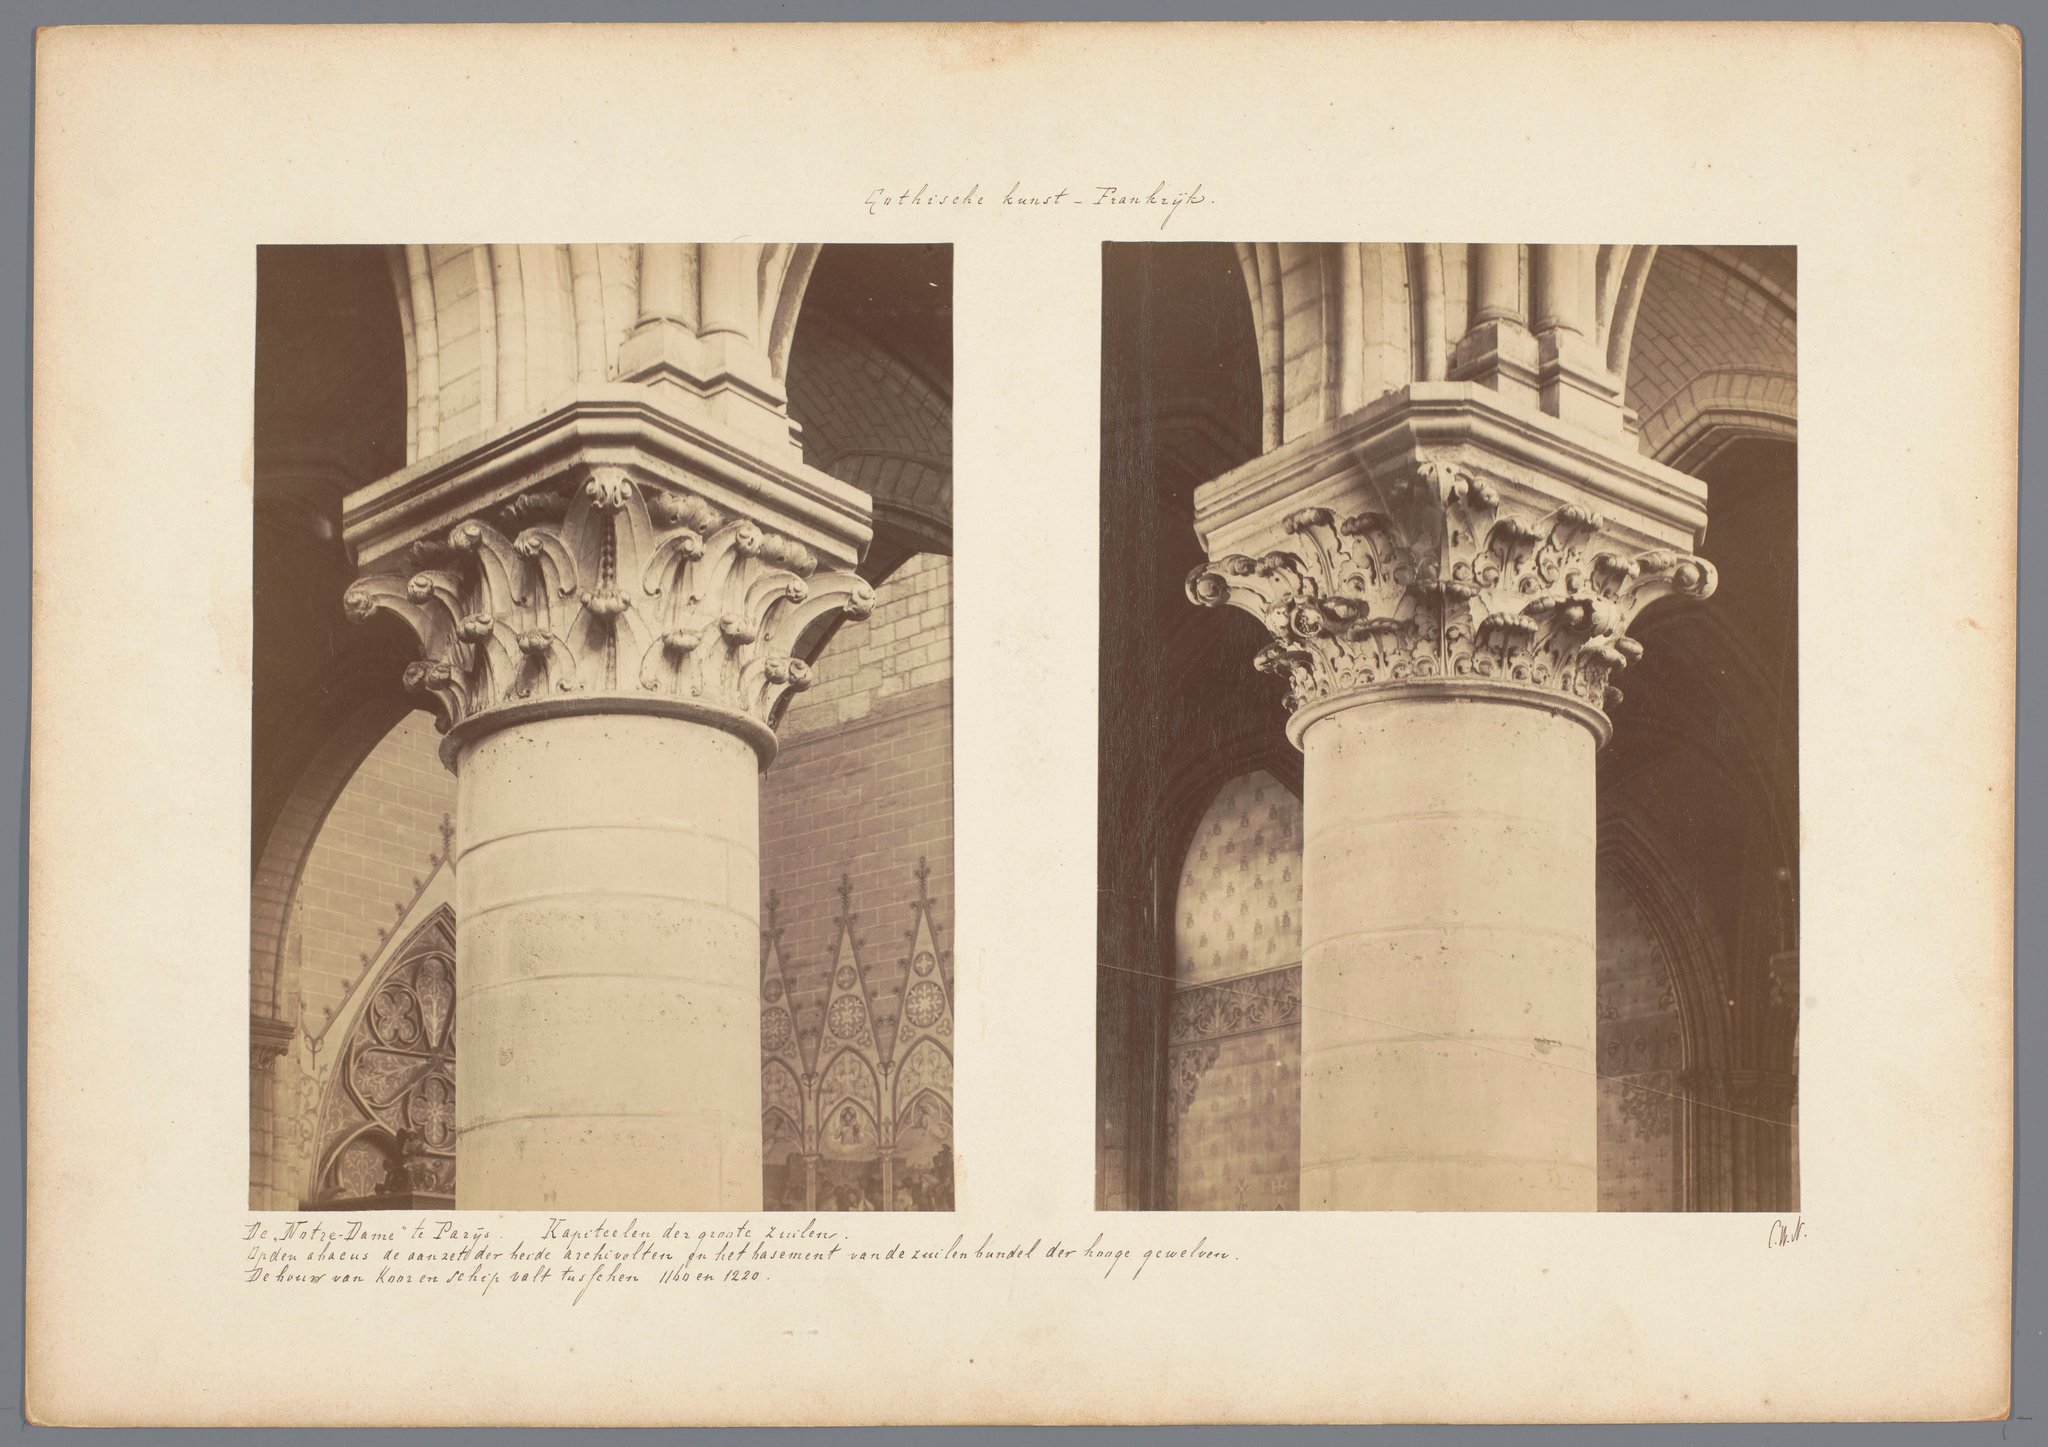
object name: photograph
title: Overzicht van twee kapitelen in de Notre-Dame te Parijs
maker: Anonymous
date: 1875-1900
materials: cardboard, photographic support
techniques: albumen print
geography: notre-dame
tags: acanthus ~ ornament, interior of church, capital (~ column, pillar)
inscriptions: inscription: ‘CWN.’, name: ‘Gothische Kunst - Frankrijk. De ,,Notre-Dame'' te Parijs. (...) De bouw van Koor en schip valt tusschen 1160 en 1220.’, collector's mark: ‘INSTITUUT VOOR KUNST- NIJVERHEIDSONDERWIJS GABRIËL METSUSTRAAT No. 16. AMSTERDAM’, collector's mark: ‘KUNSTNIJVERHEIDSCHOOL QUELLINUS AMSTERDAM FRANS HALSSTRAAT 14.’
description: Links een kapiteel met gestyleerd acanthusbladmotief, rechts een kapiteel met acanthusbladmotief.